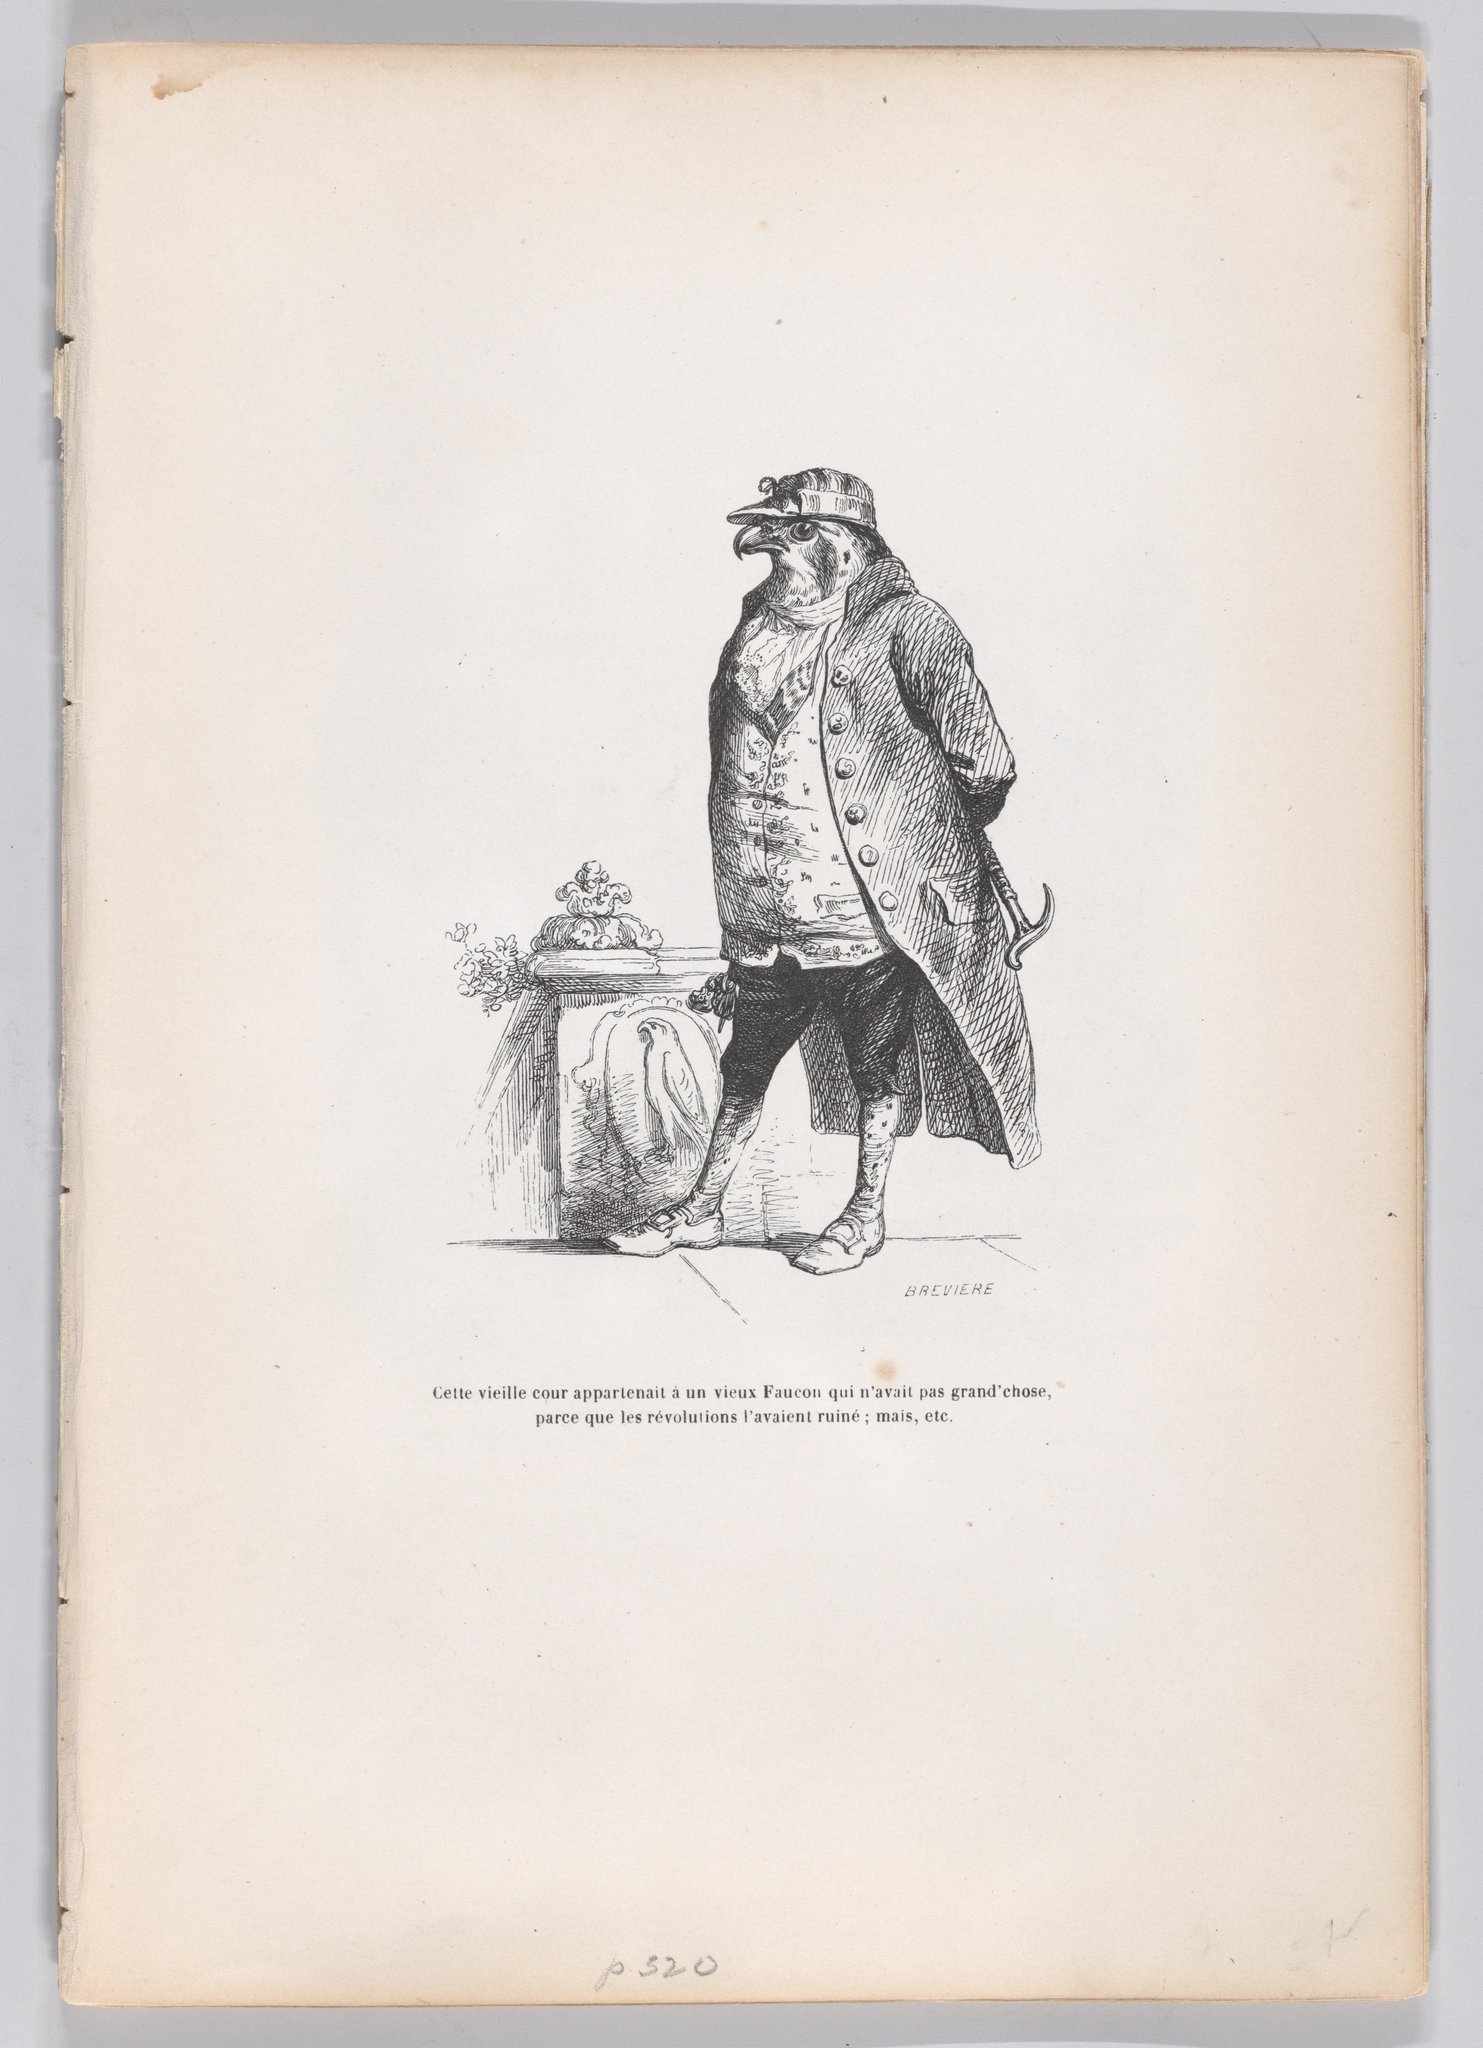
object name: print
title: This old court apparently has an old falcon..., from "Scenes from the Private and Public Life of Animals"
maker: j. j. grandville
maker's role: illustrator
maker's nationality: french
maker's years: 1803-1847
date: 1837-1847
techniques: engraving